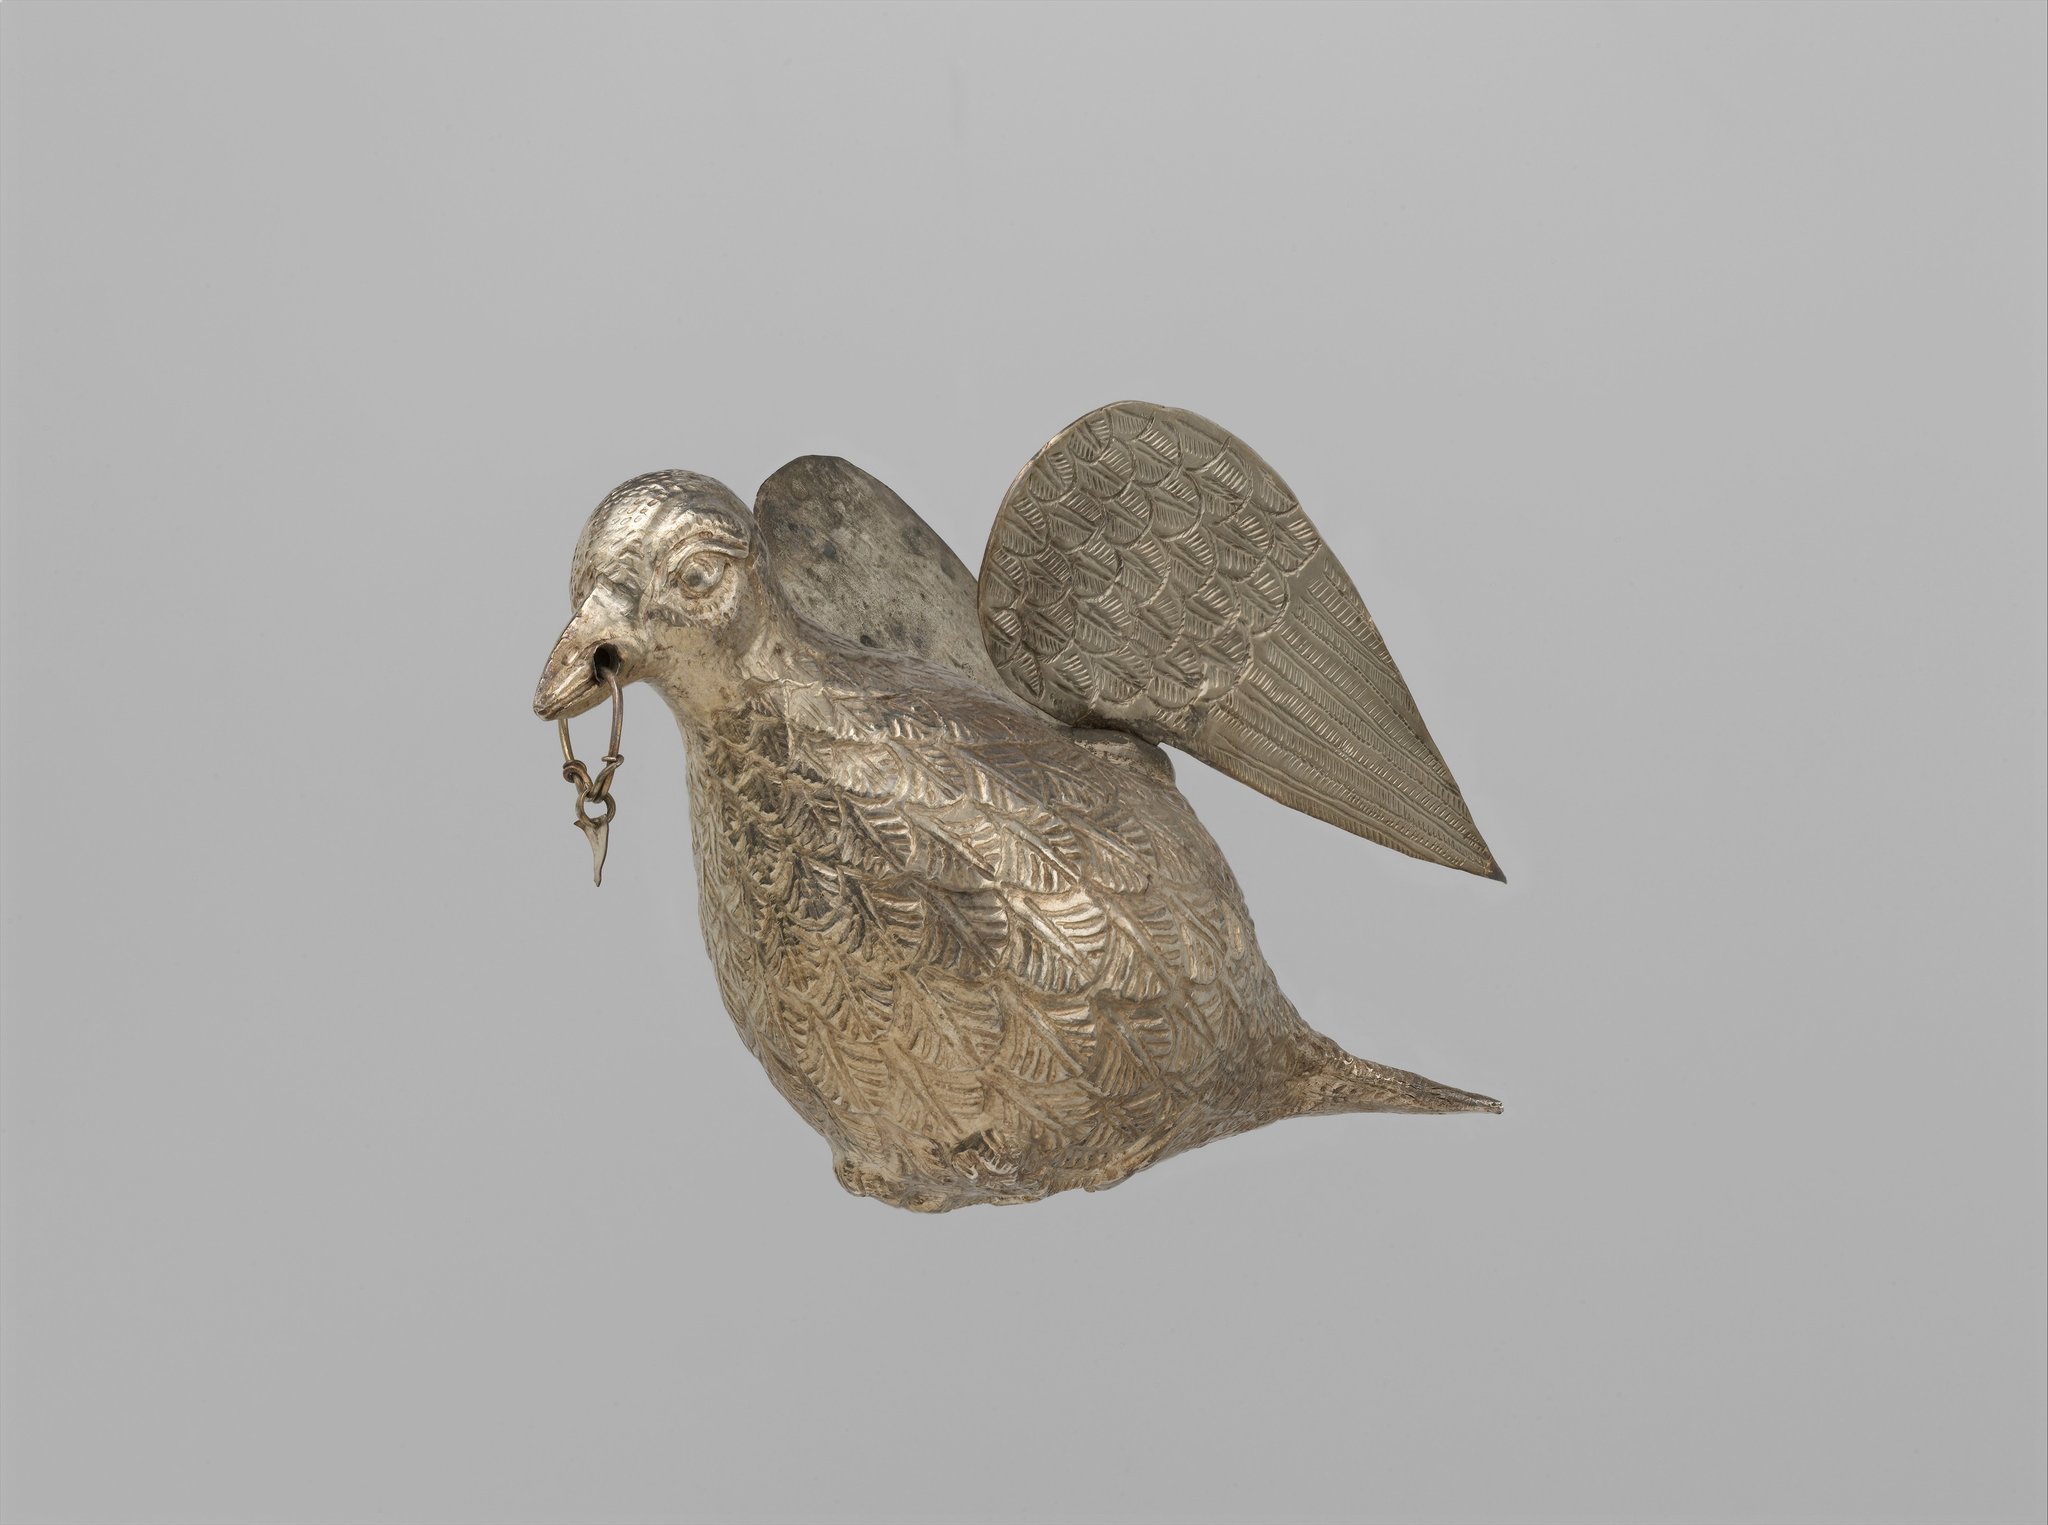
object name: liturgical dove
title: The Attarouthi Treasure - Silver Dove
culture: byzantine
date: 500-650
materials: silver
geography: syria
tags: doves